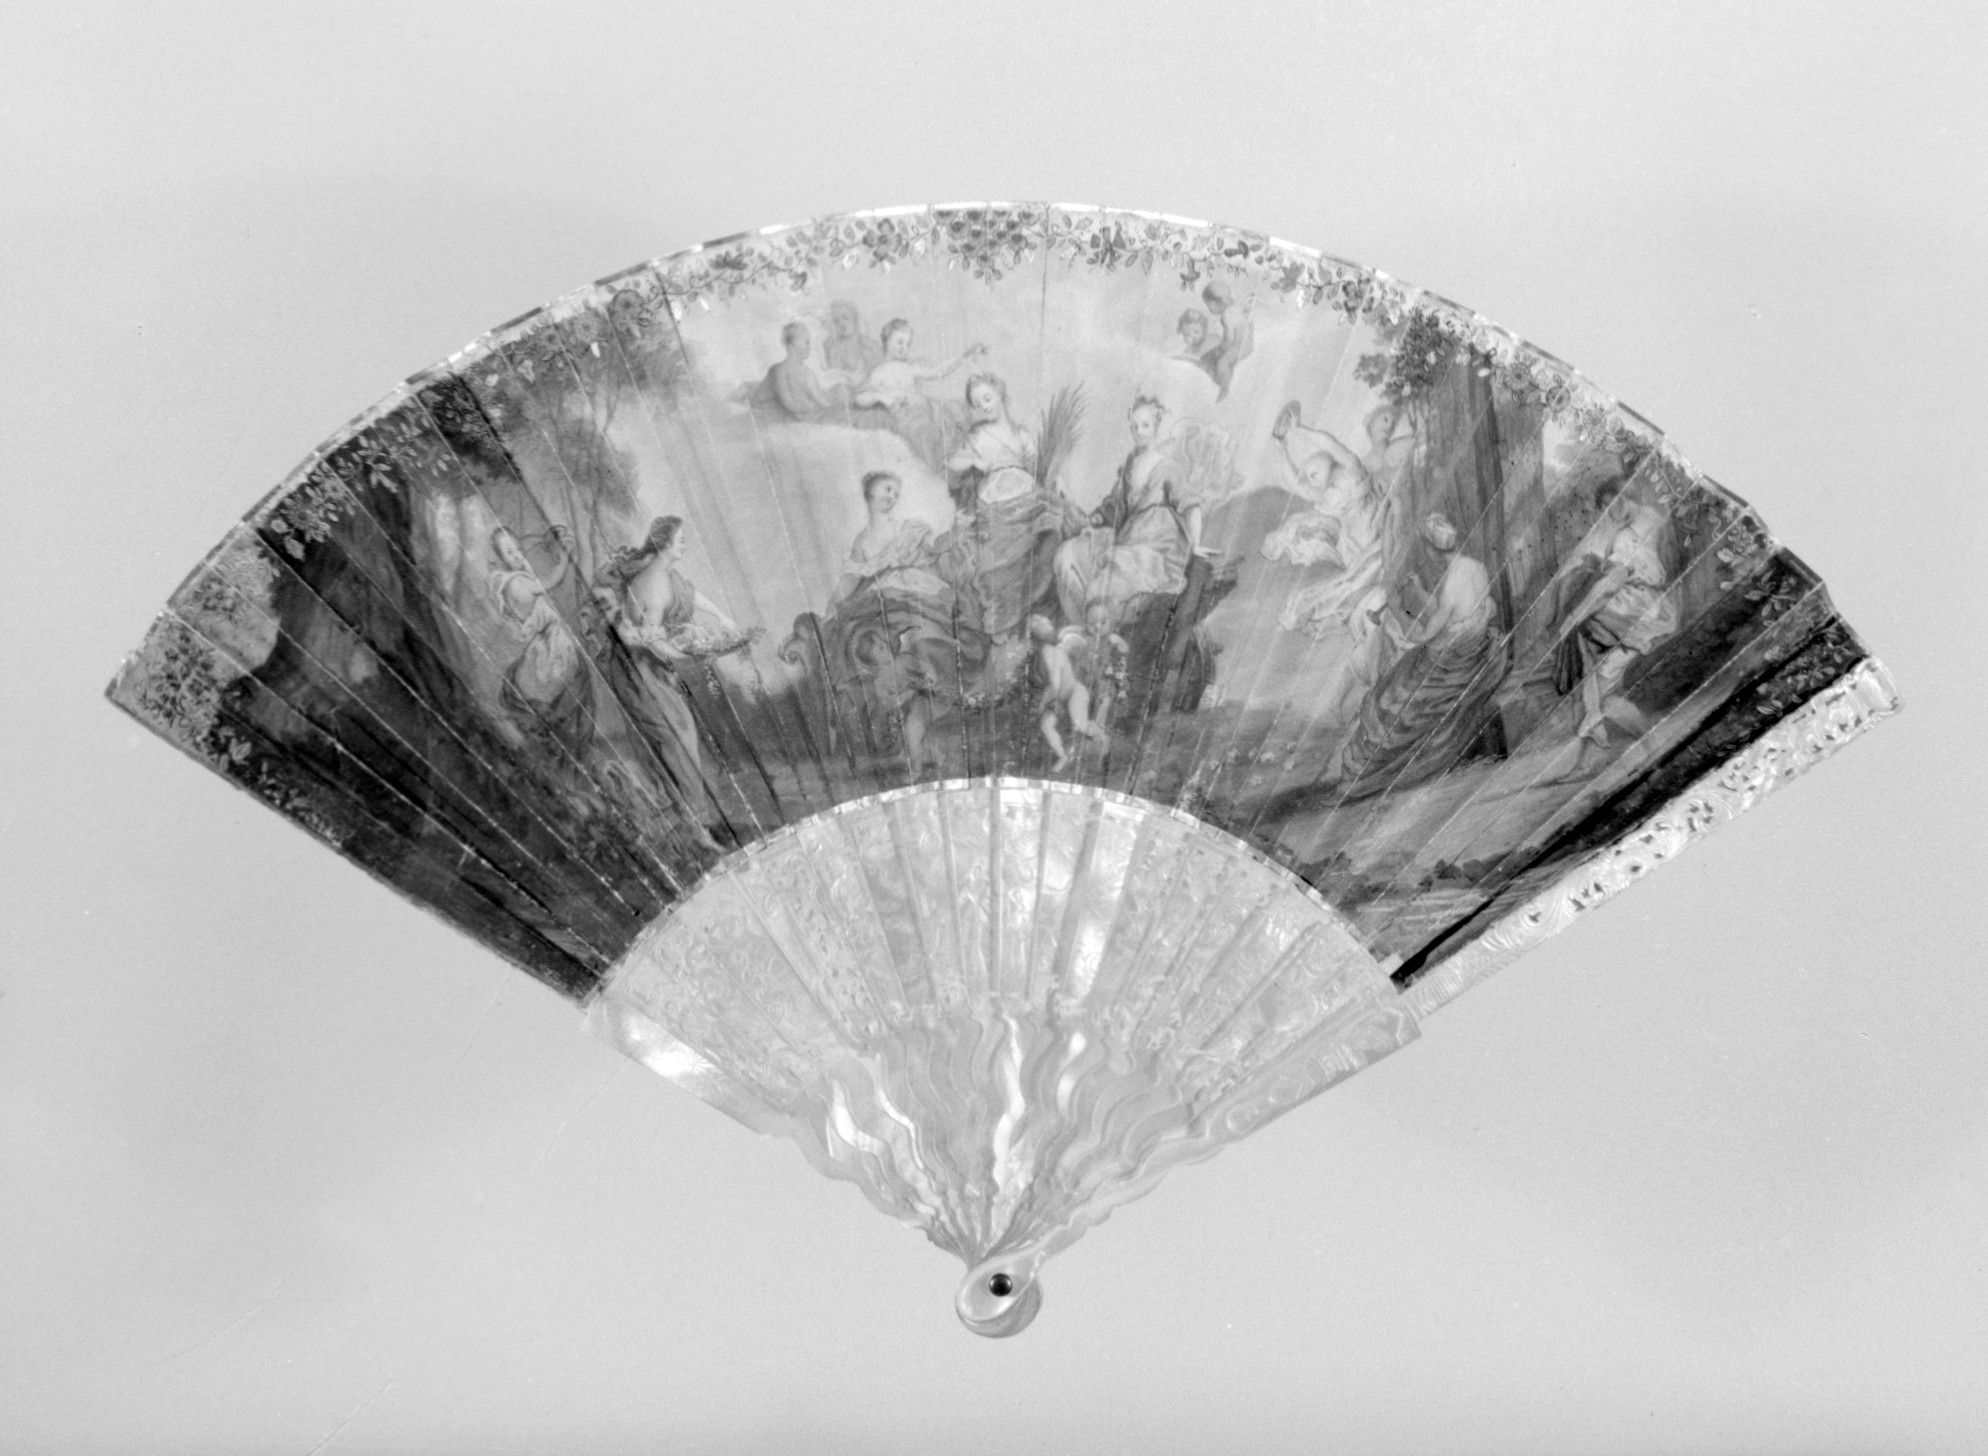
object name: fan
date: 1701-1800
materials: mother of pearl, paper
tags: women,putti